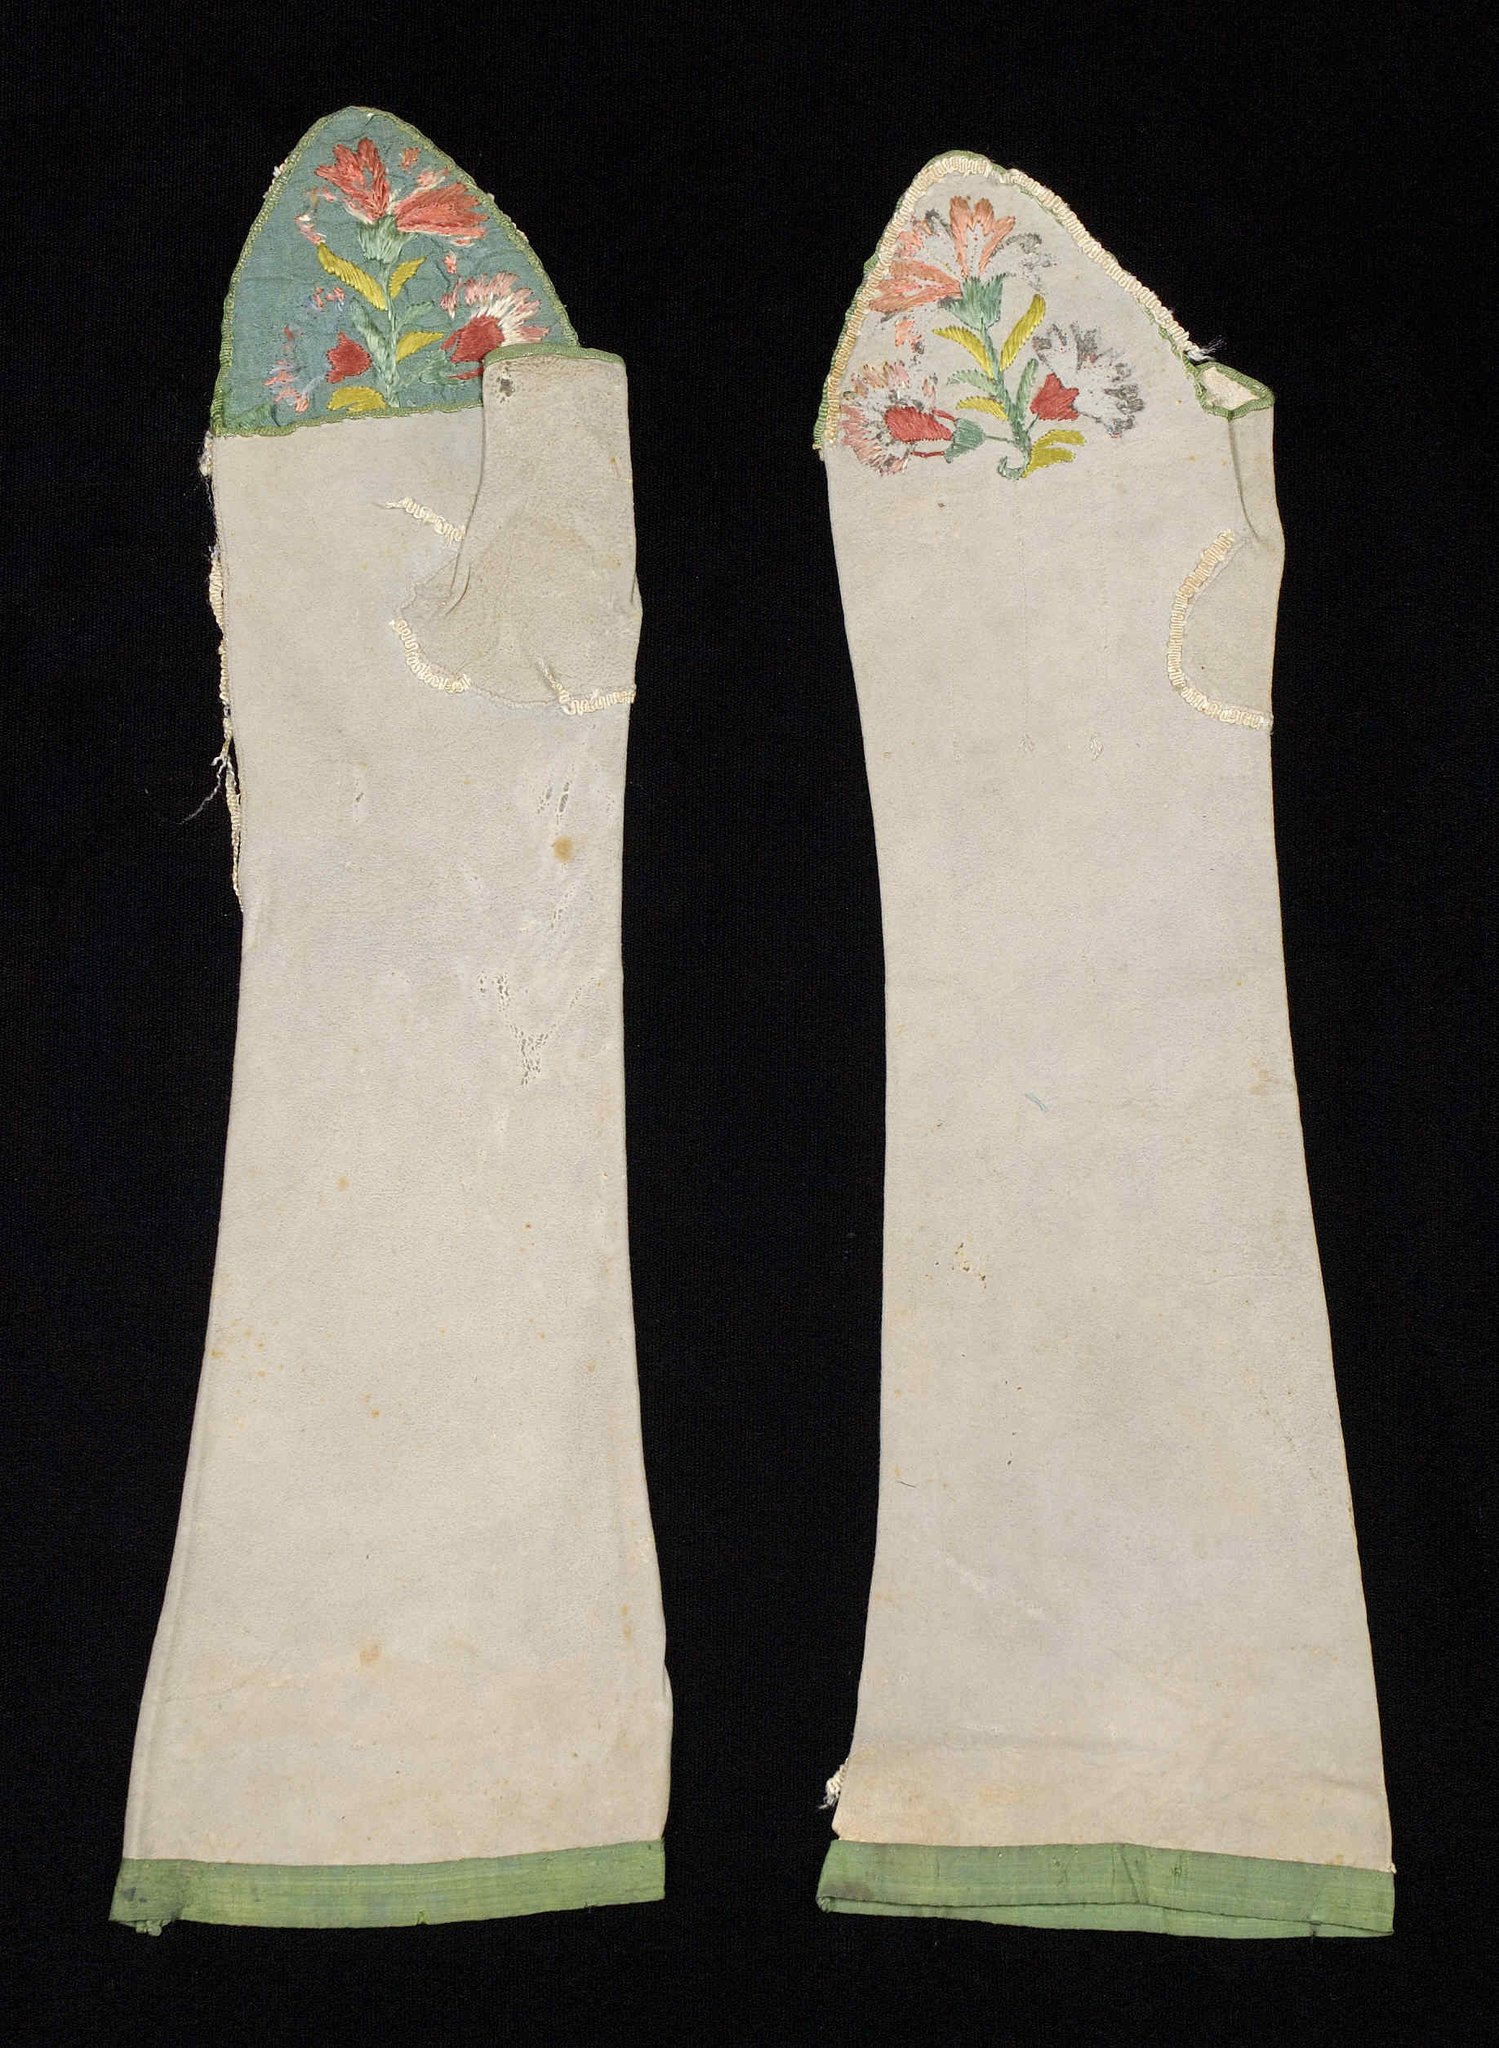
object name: mitt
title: Mitts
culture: spanish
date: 1667-1700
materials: leather, silk